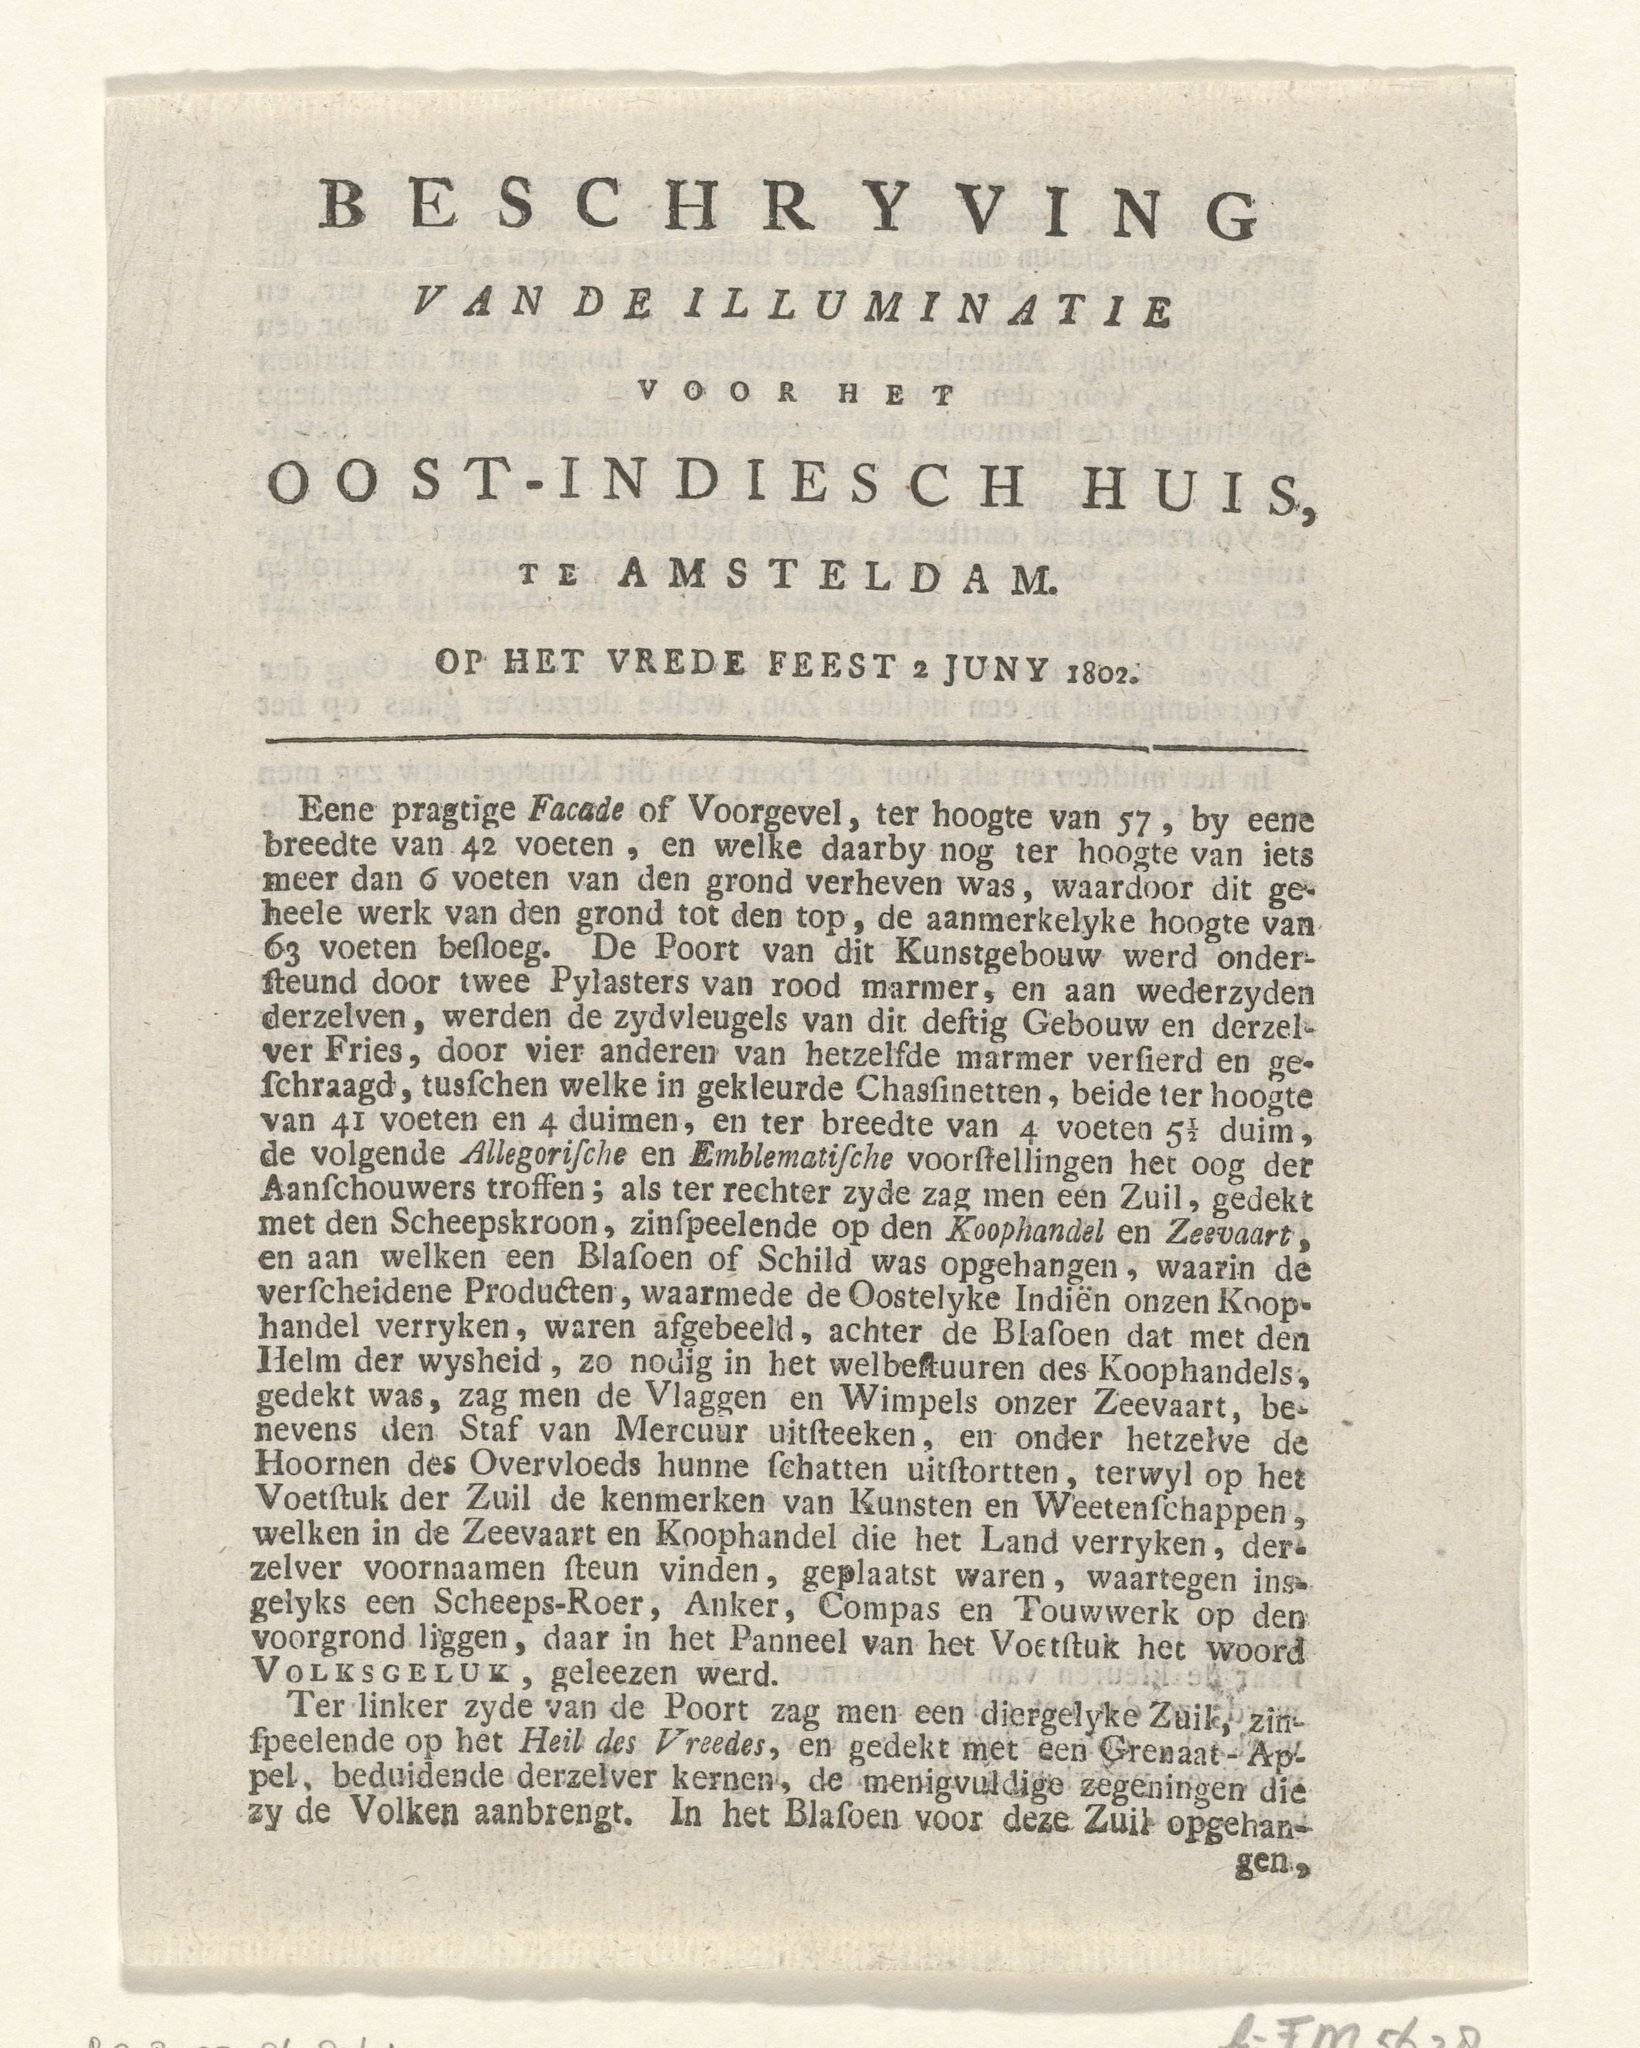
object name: text sheet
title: Beschryving van de Illuminatie voor het Oost-Indiesch Huis, te Amsteldam. Op het Vrede Feest 2 Juny 1802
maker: Anonymous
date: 1802-1803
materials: paper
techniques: letterpress printing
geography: netherlands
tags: oost-indisch huis, vrede van amiens (1802)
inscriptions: collector's mark: Lugt 2228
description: Tekstblad met een beschrijving van de illuminatie opgericht voor het Oost-Indisch Huis te Amsterdam, bij de feestelijke viering van de Vrede van Amiens op 2 juni 1802. Blad bedrukt op beide zijden.